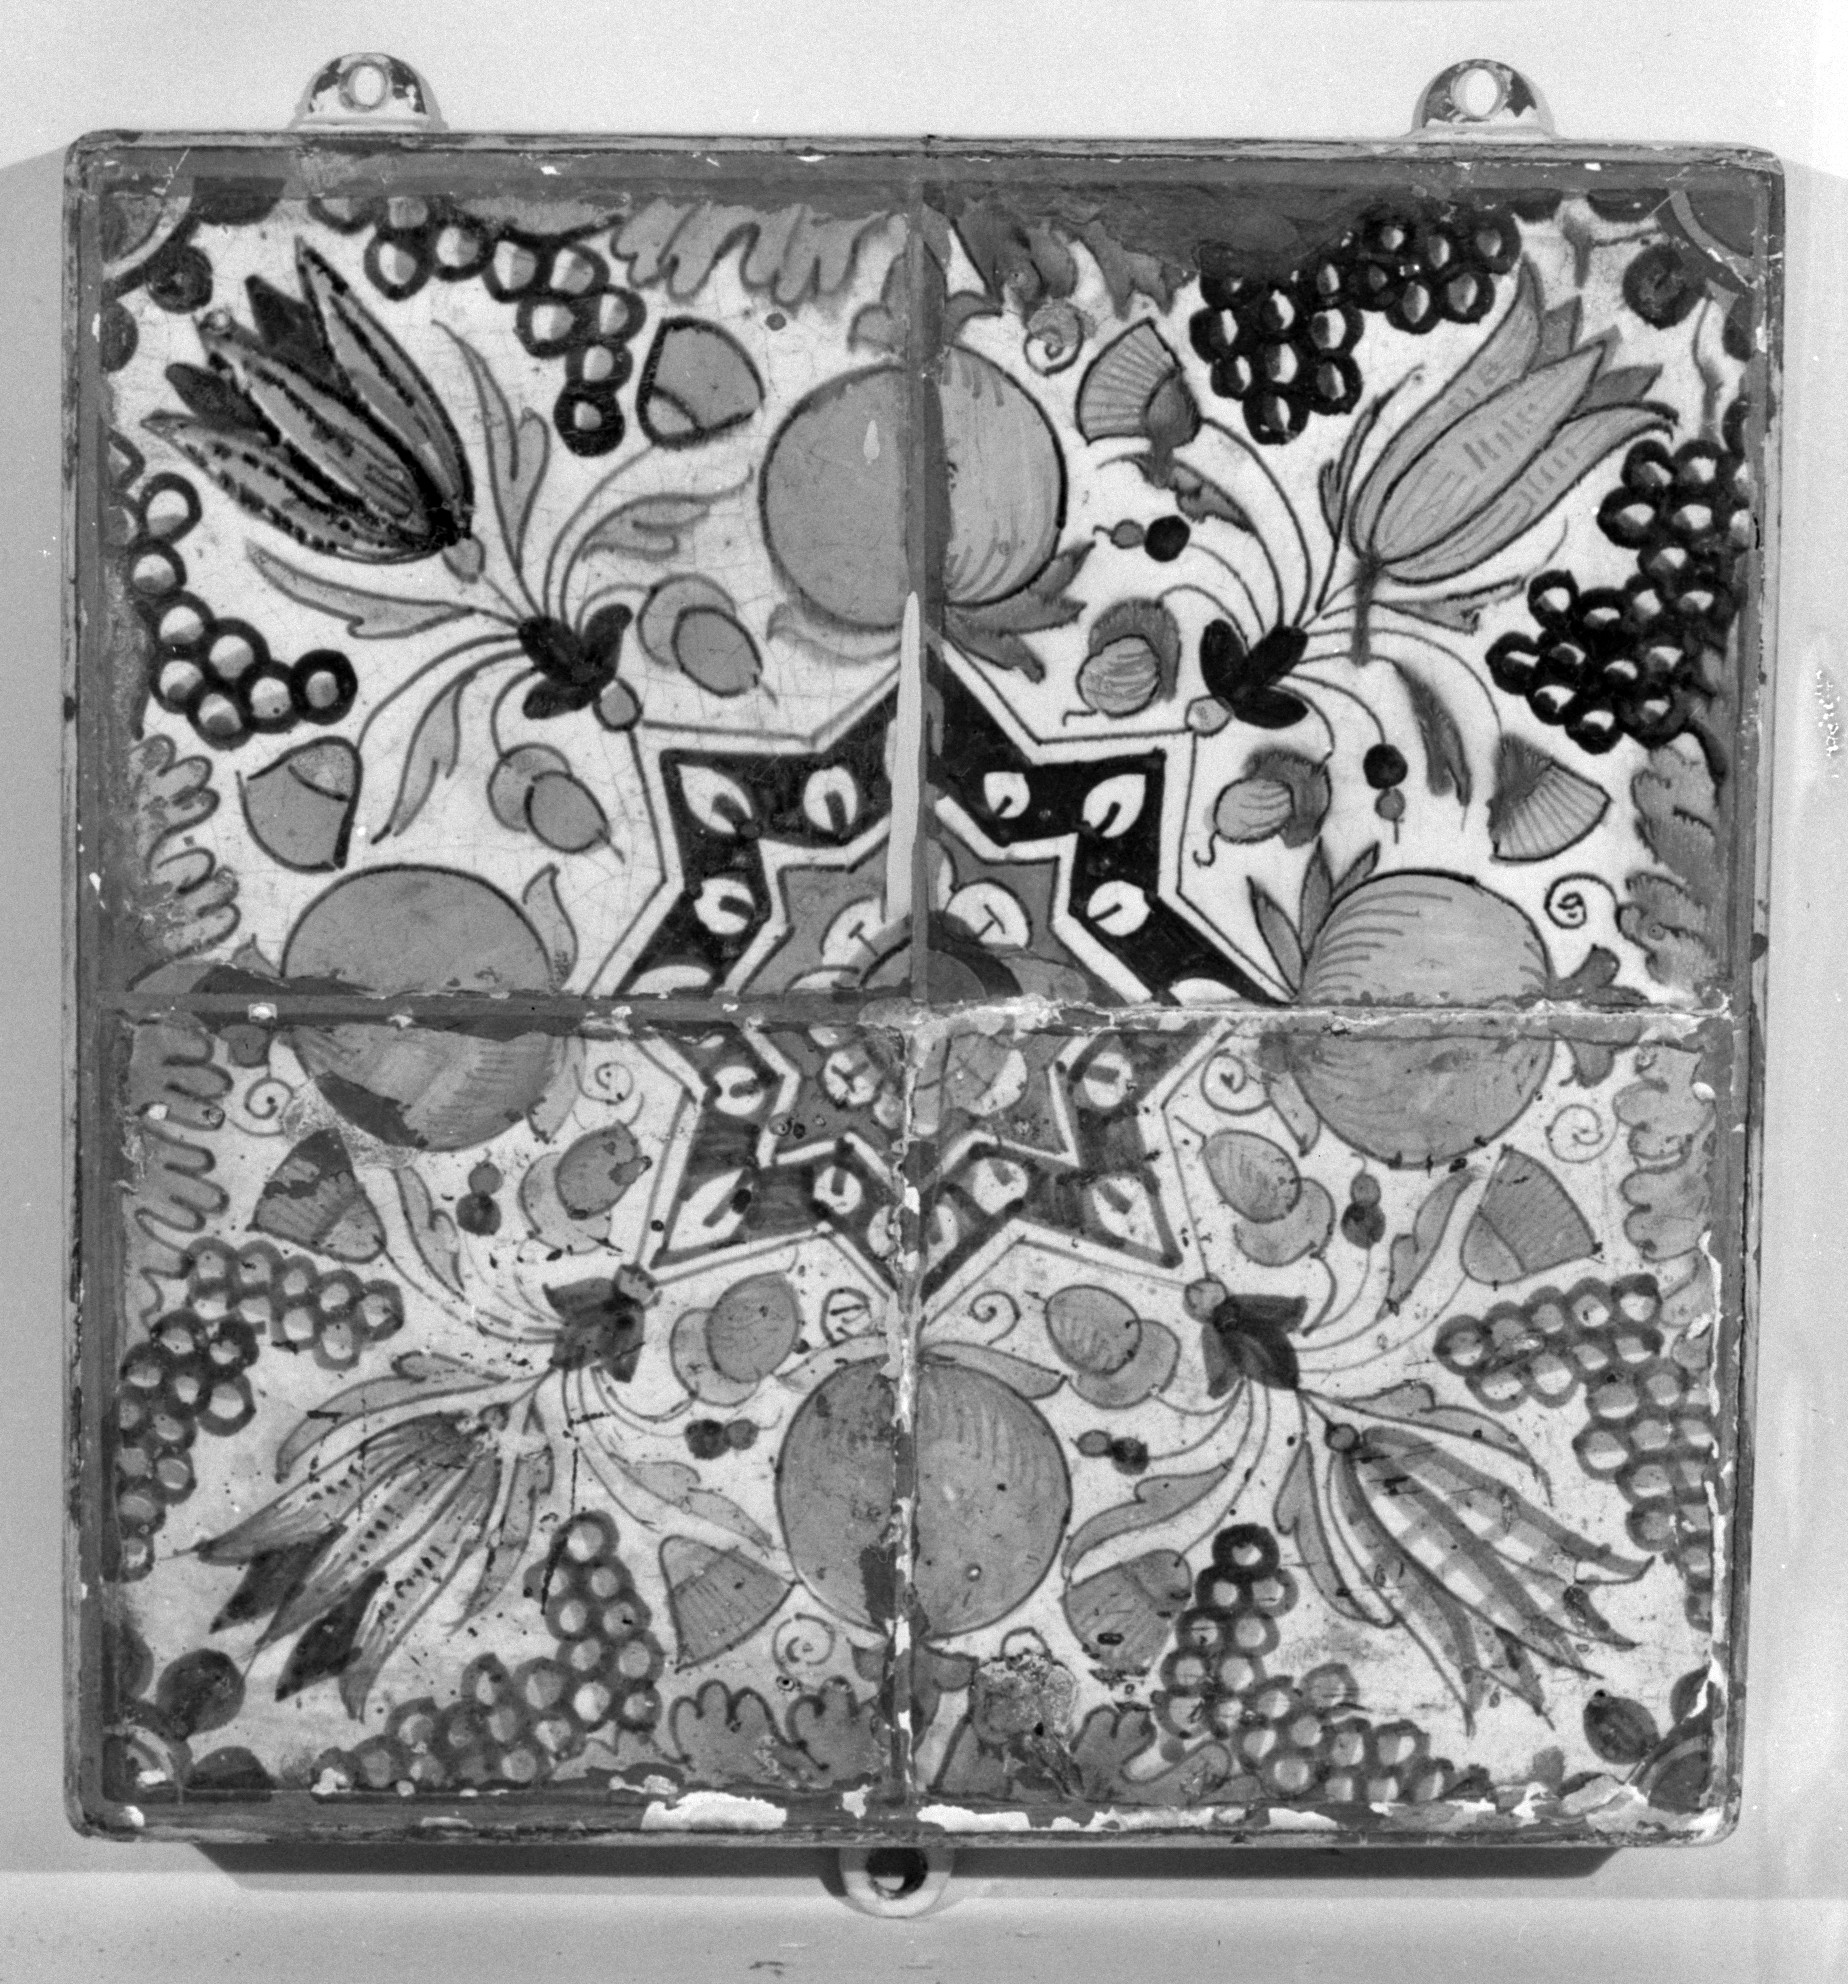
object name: tile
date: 1601-1625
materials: earthenware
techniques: glazing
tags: flowers